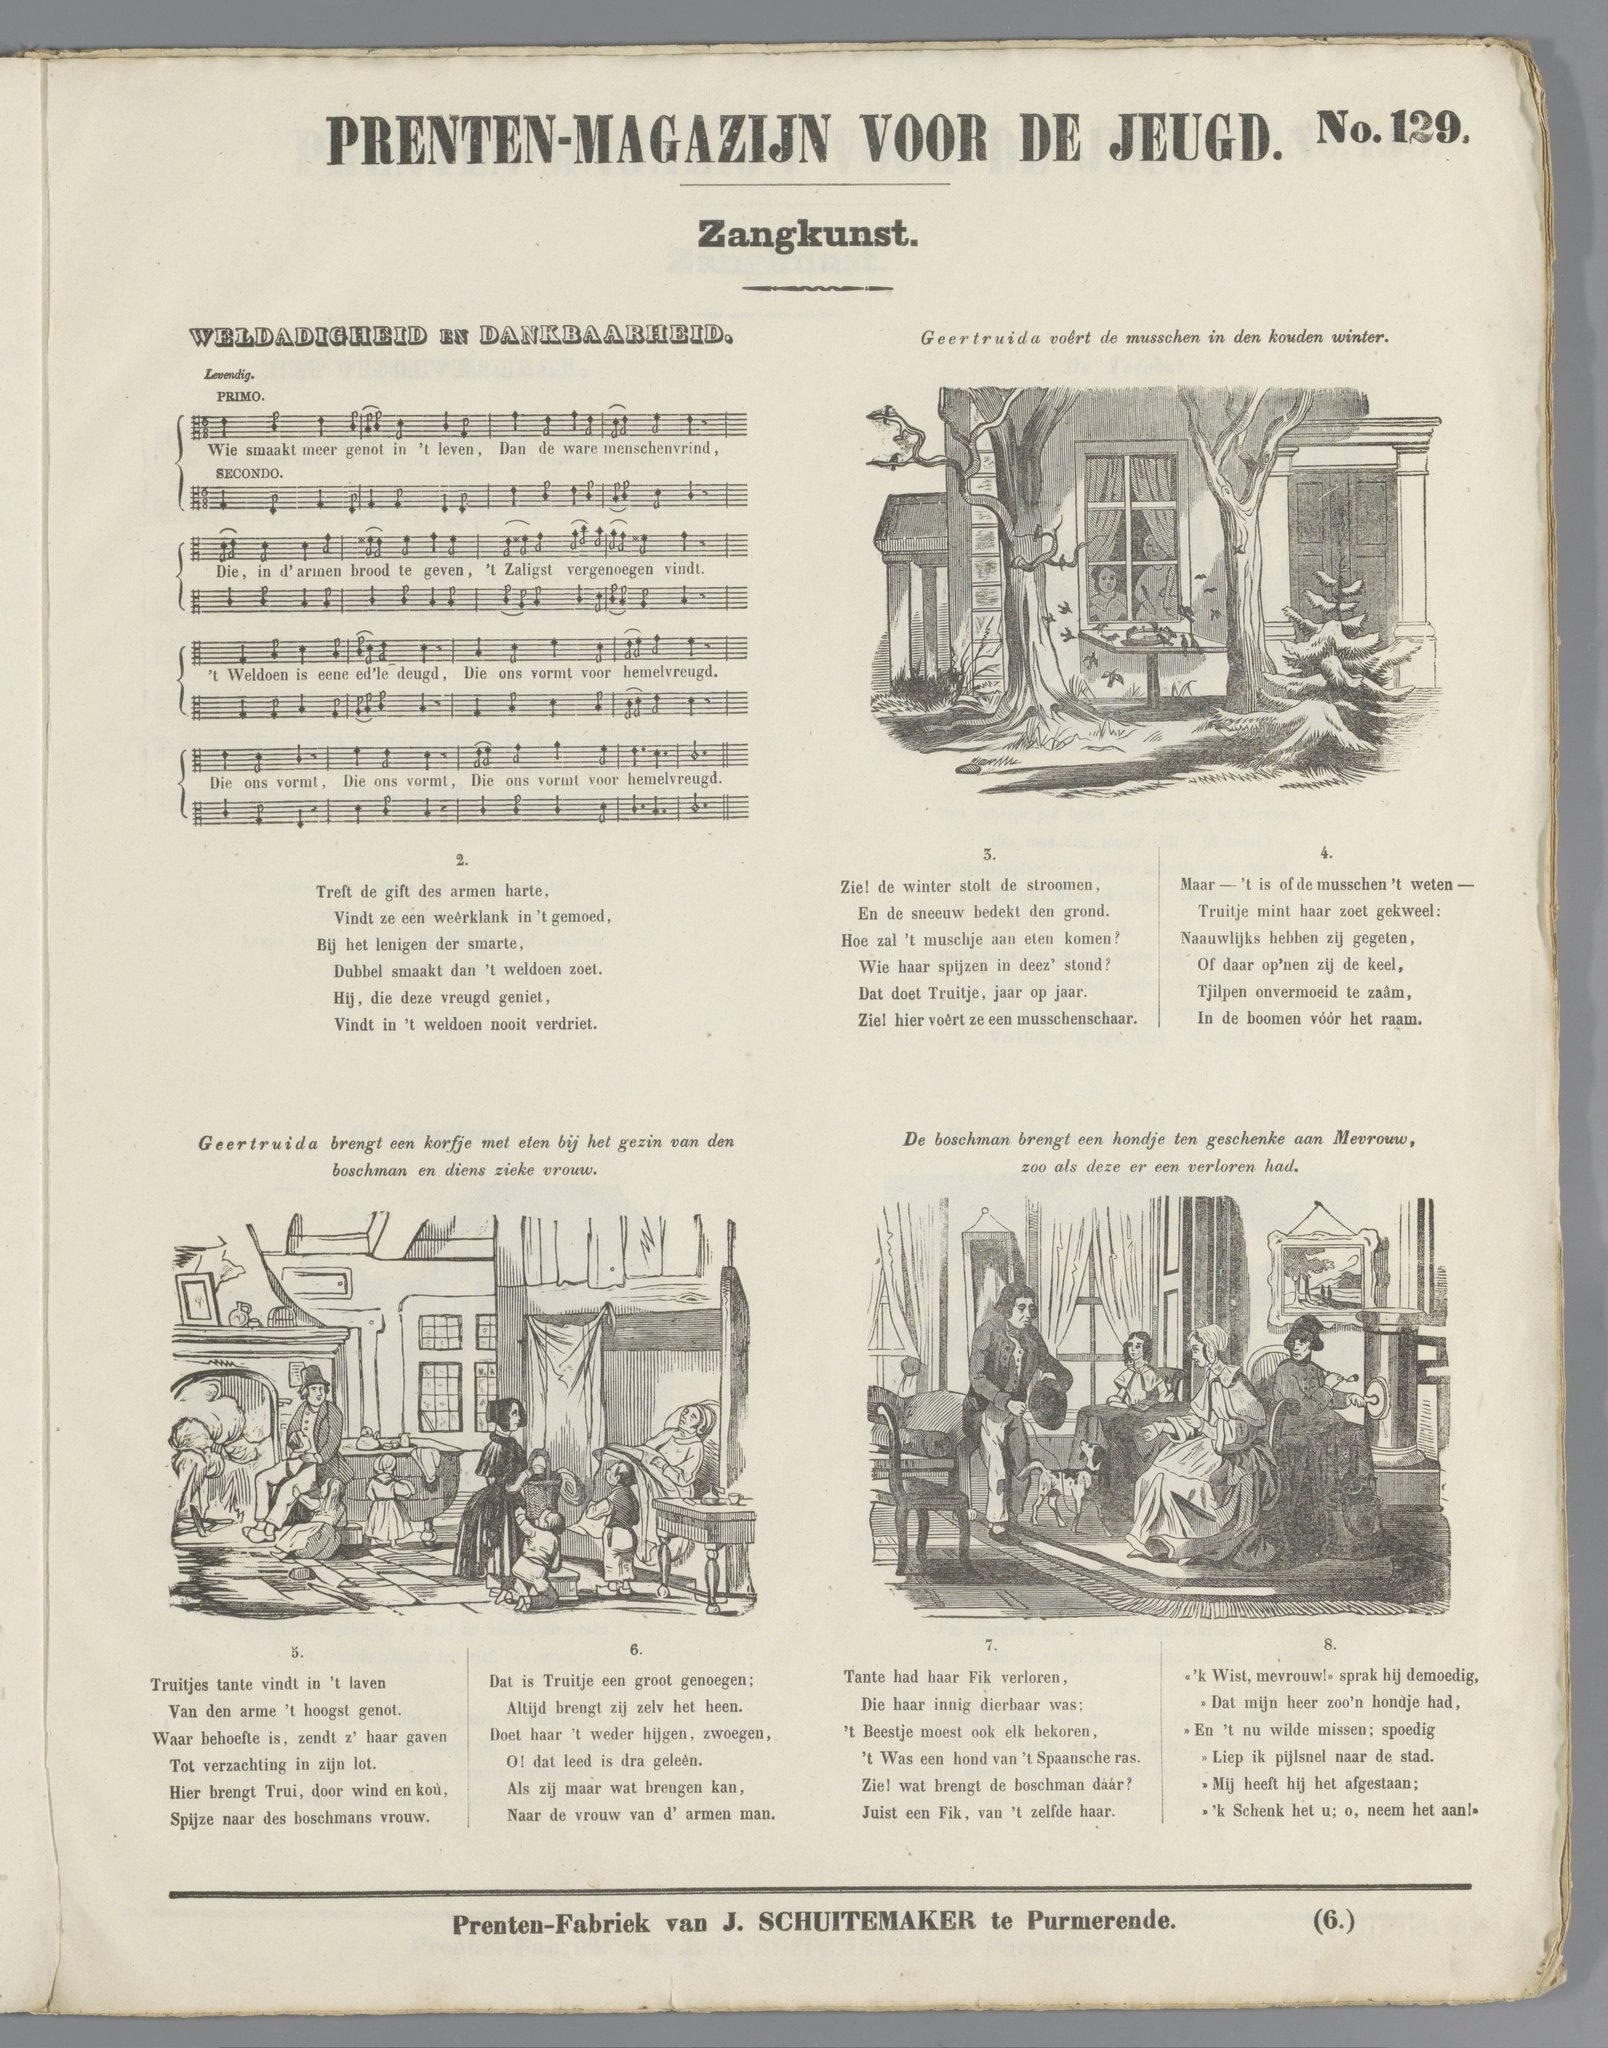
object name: print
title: Groot en goed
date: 1853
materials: paper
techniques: letterpress printing, engraving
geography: purmerend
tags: gifts being accepted, printed edition of musical score, feeding wild animals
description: Blad met muziekstuk 'Weldadigheid en dankbaarheid' en 3 voorstellingen: Geertruida voert de mussen in de koude winter, Geertruida brengt een korfje met eten bij het gezin van den boschman en diens zieke vrouw en de boschman brengt een hondje ten geschenke aan mevrouw, zoo als deze er een verloren had. Onder de voorstellingen diverse coupletten van het muziekstuk. Genummerd rechtsboven: No. 129, linksonder: (6.).